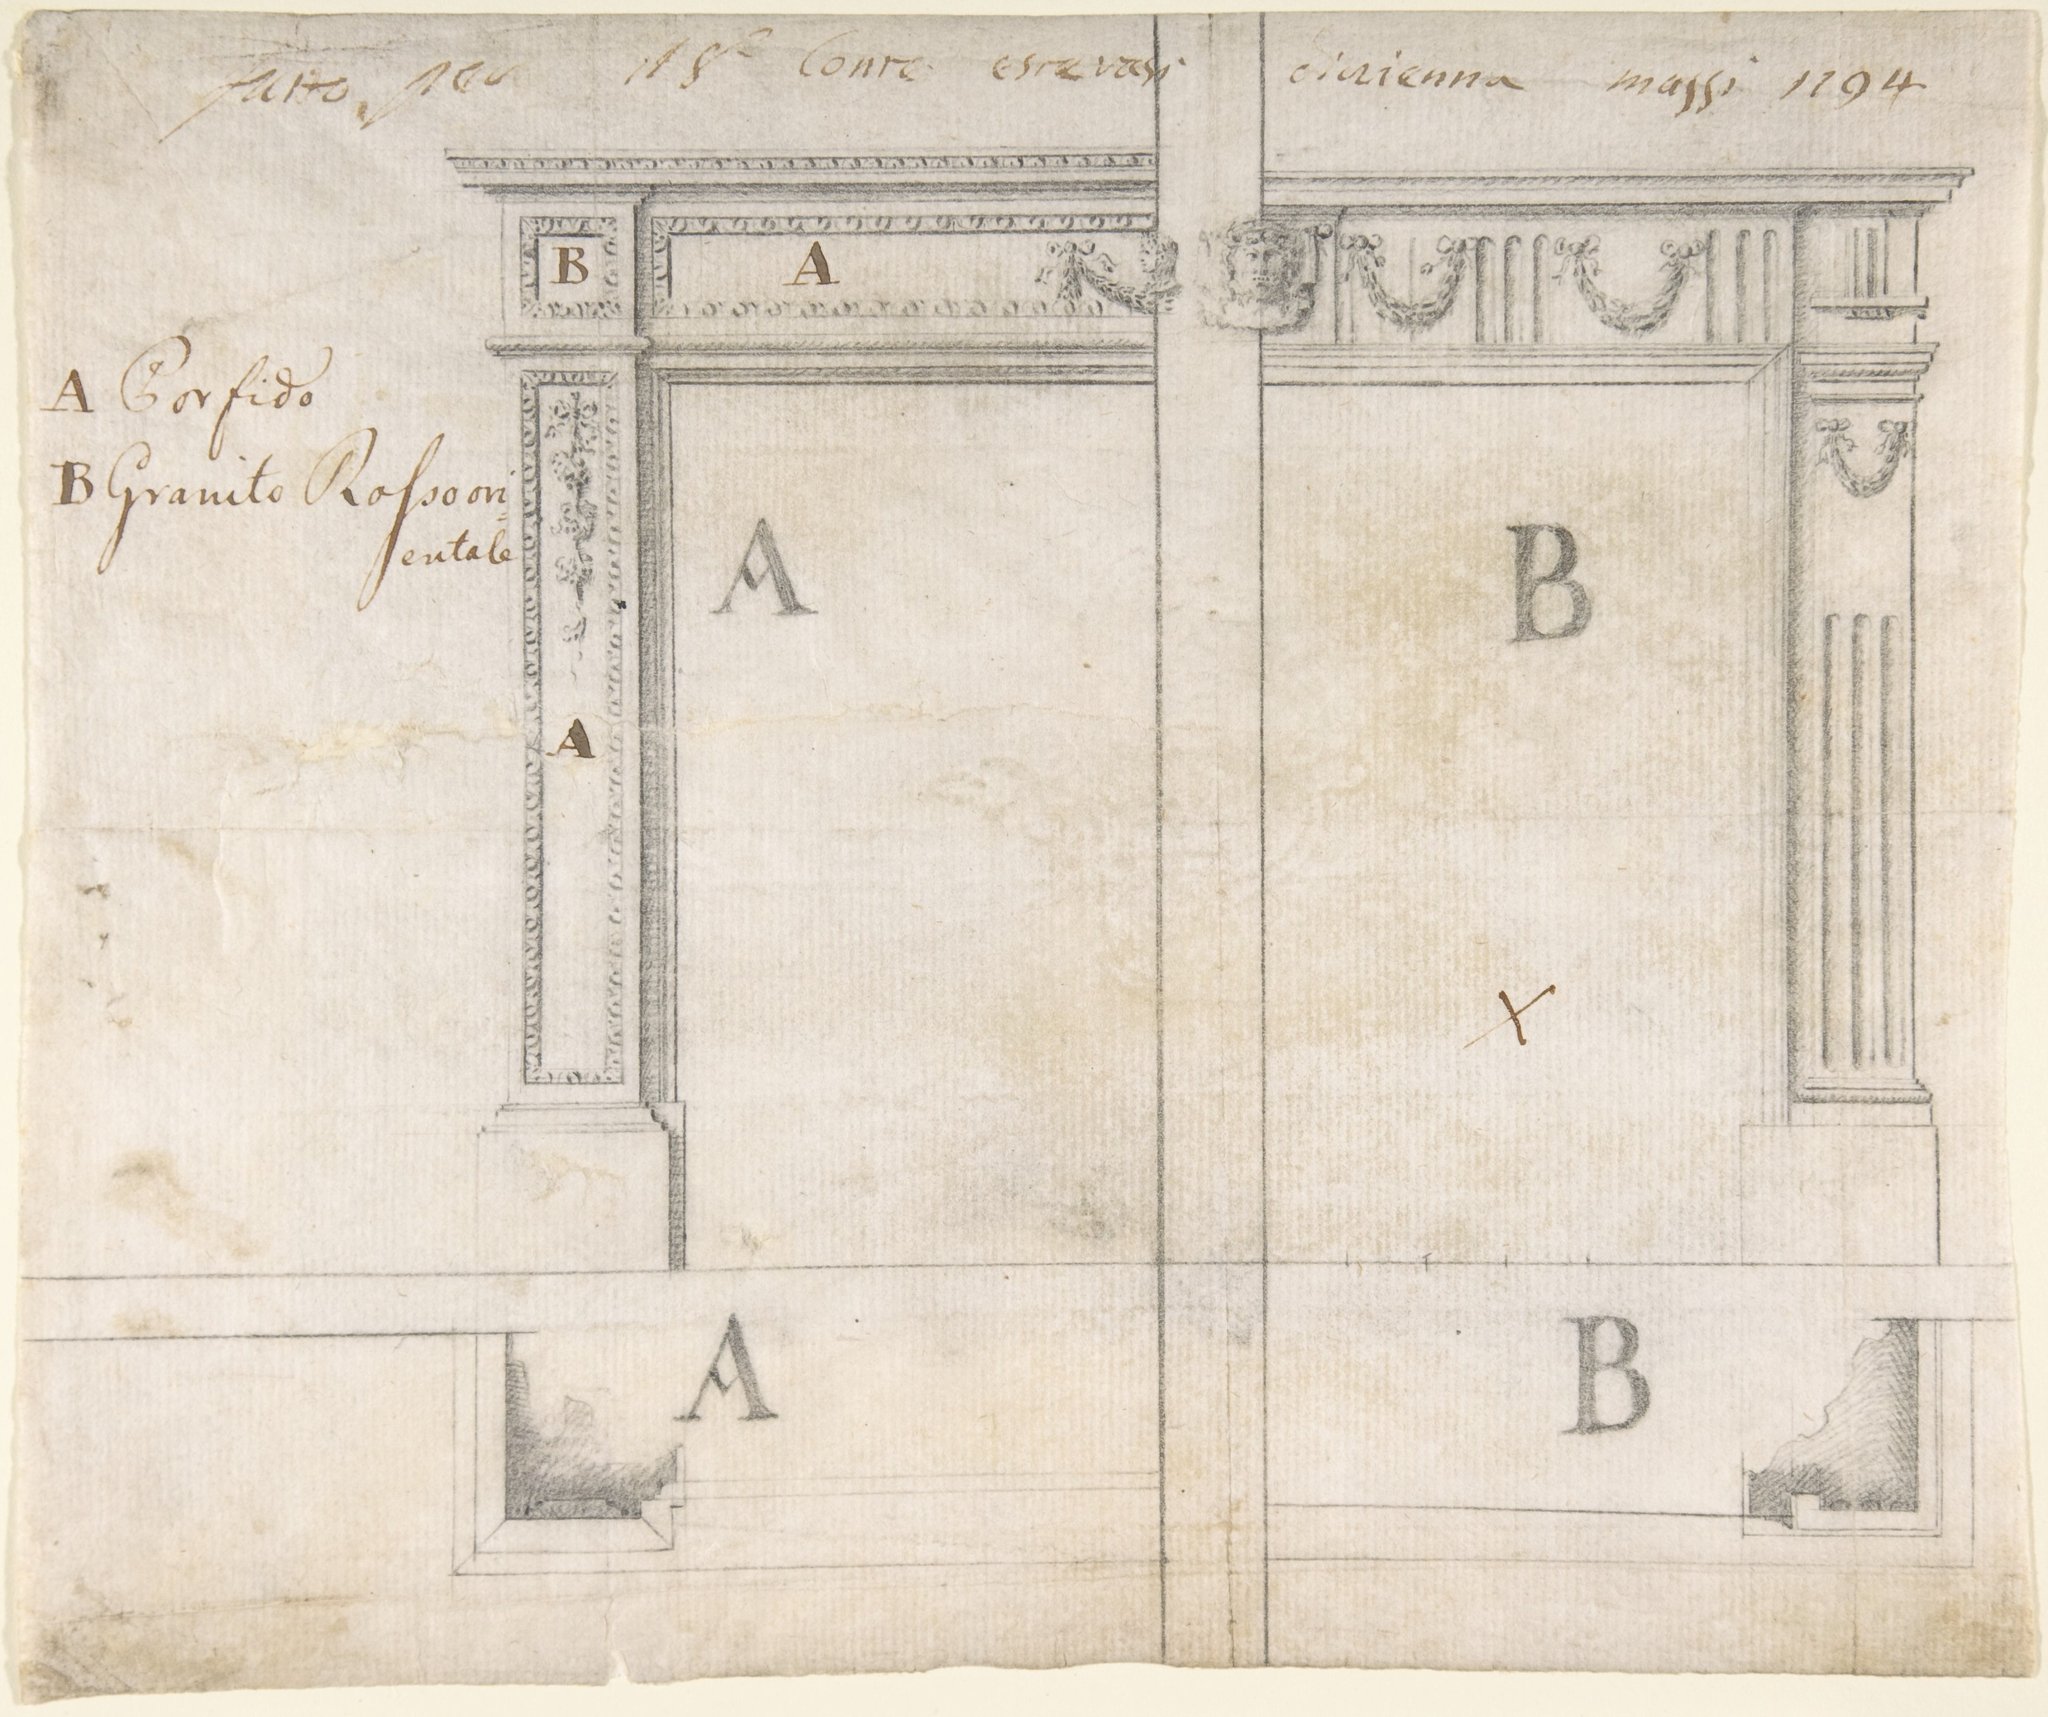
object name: drawing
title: Alternate Designs for a Chimneypiece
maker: anonymous, italian, 18th century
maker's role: artist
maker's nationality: italian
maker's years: 1700-1800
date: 1701-1800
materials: graphite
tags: architecture